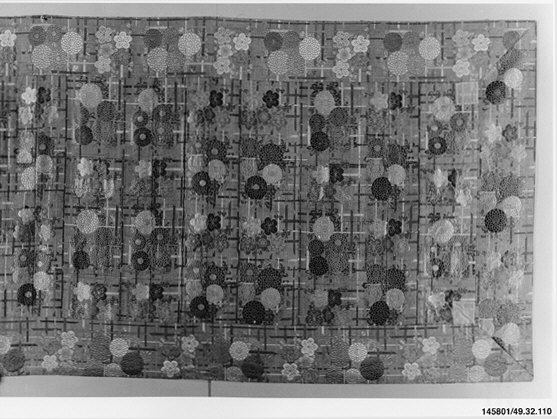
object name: robe, priest's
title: Priest's Robe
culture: japanese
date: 1701-1800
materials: metal thread, silk